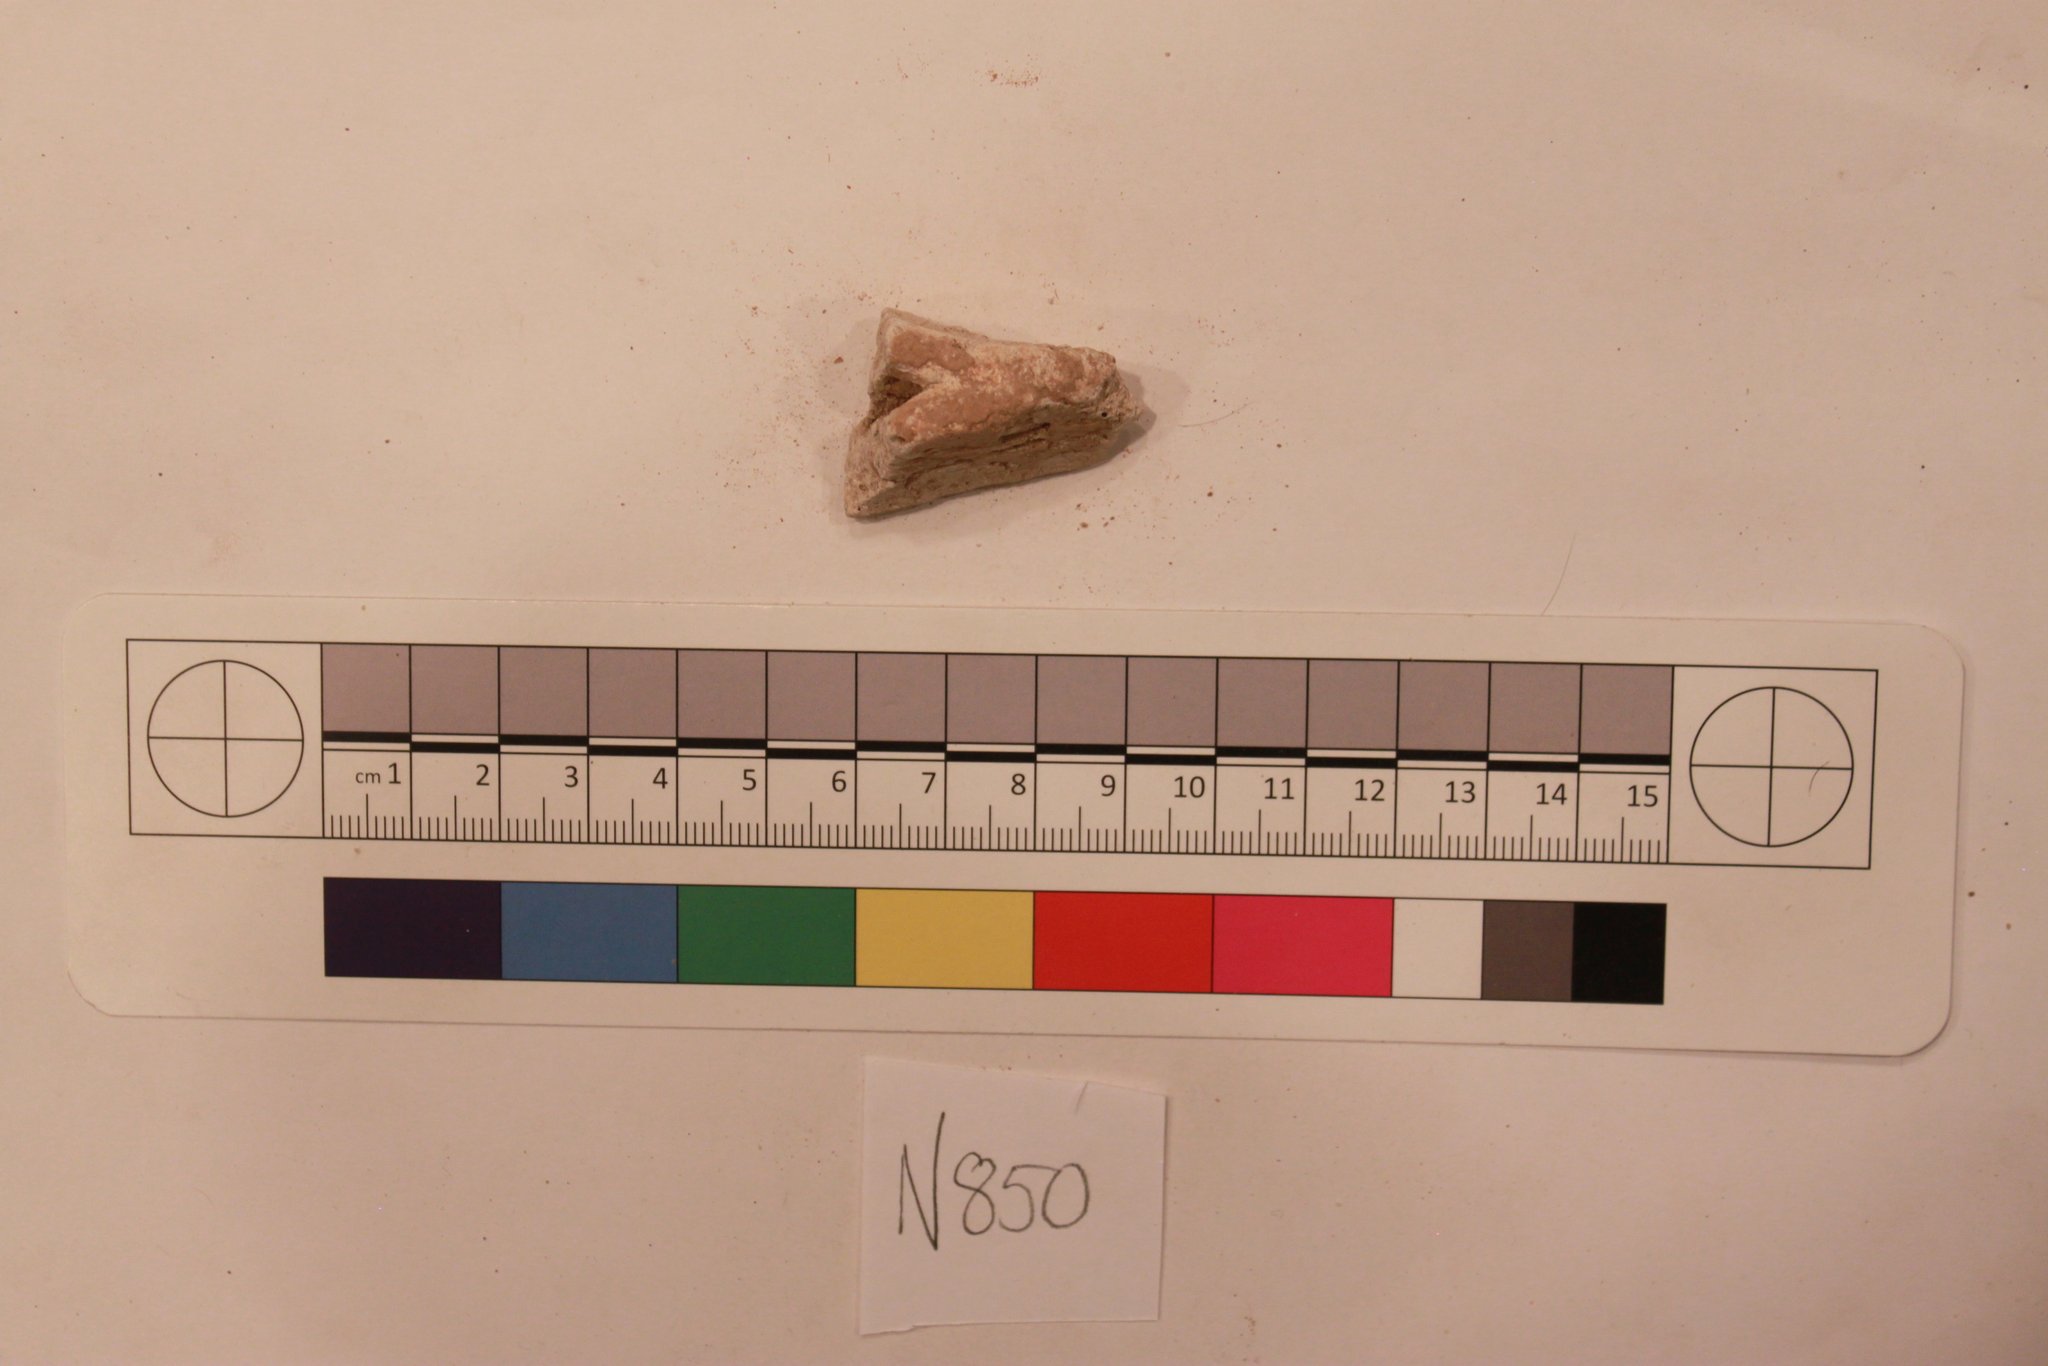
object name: fragment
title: Stucco Fragment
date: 701-1200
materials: plaster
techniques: carving, painting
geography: iran